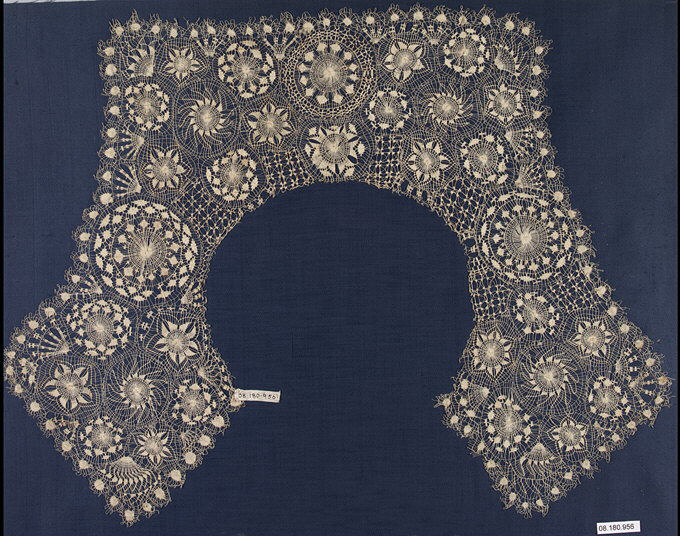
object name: collar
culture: paraguayan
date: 1801-1900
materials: silk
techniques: embroidery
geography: paraguay